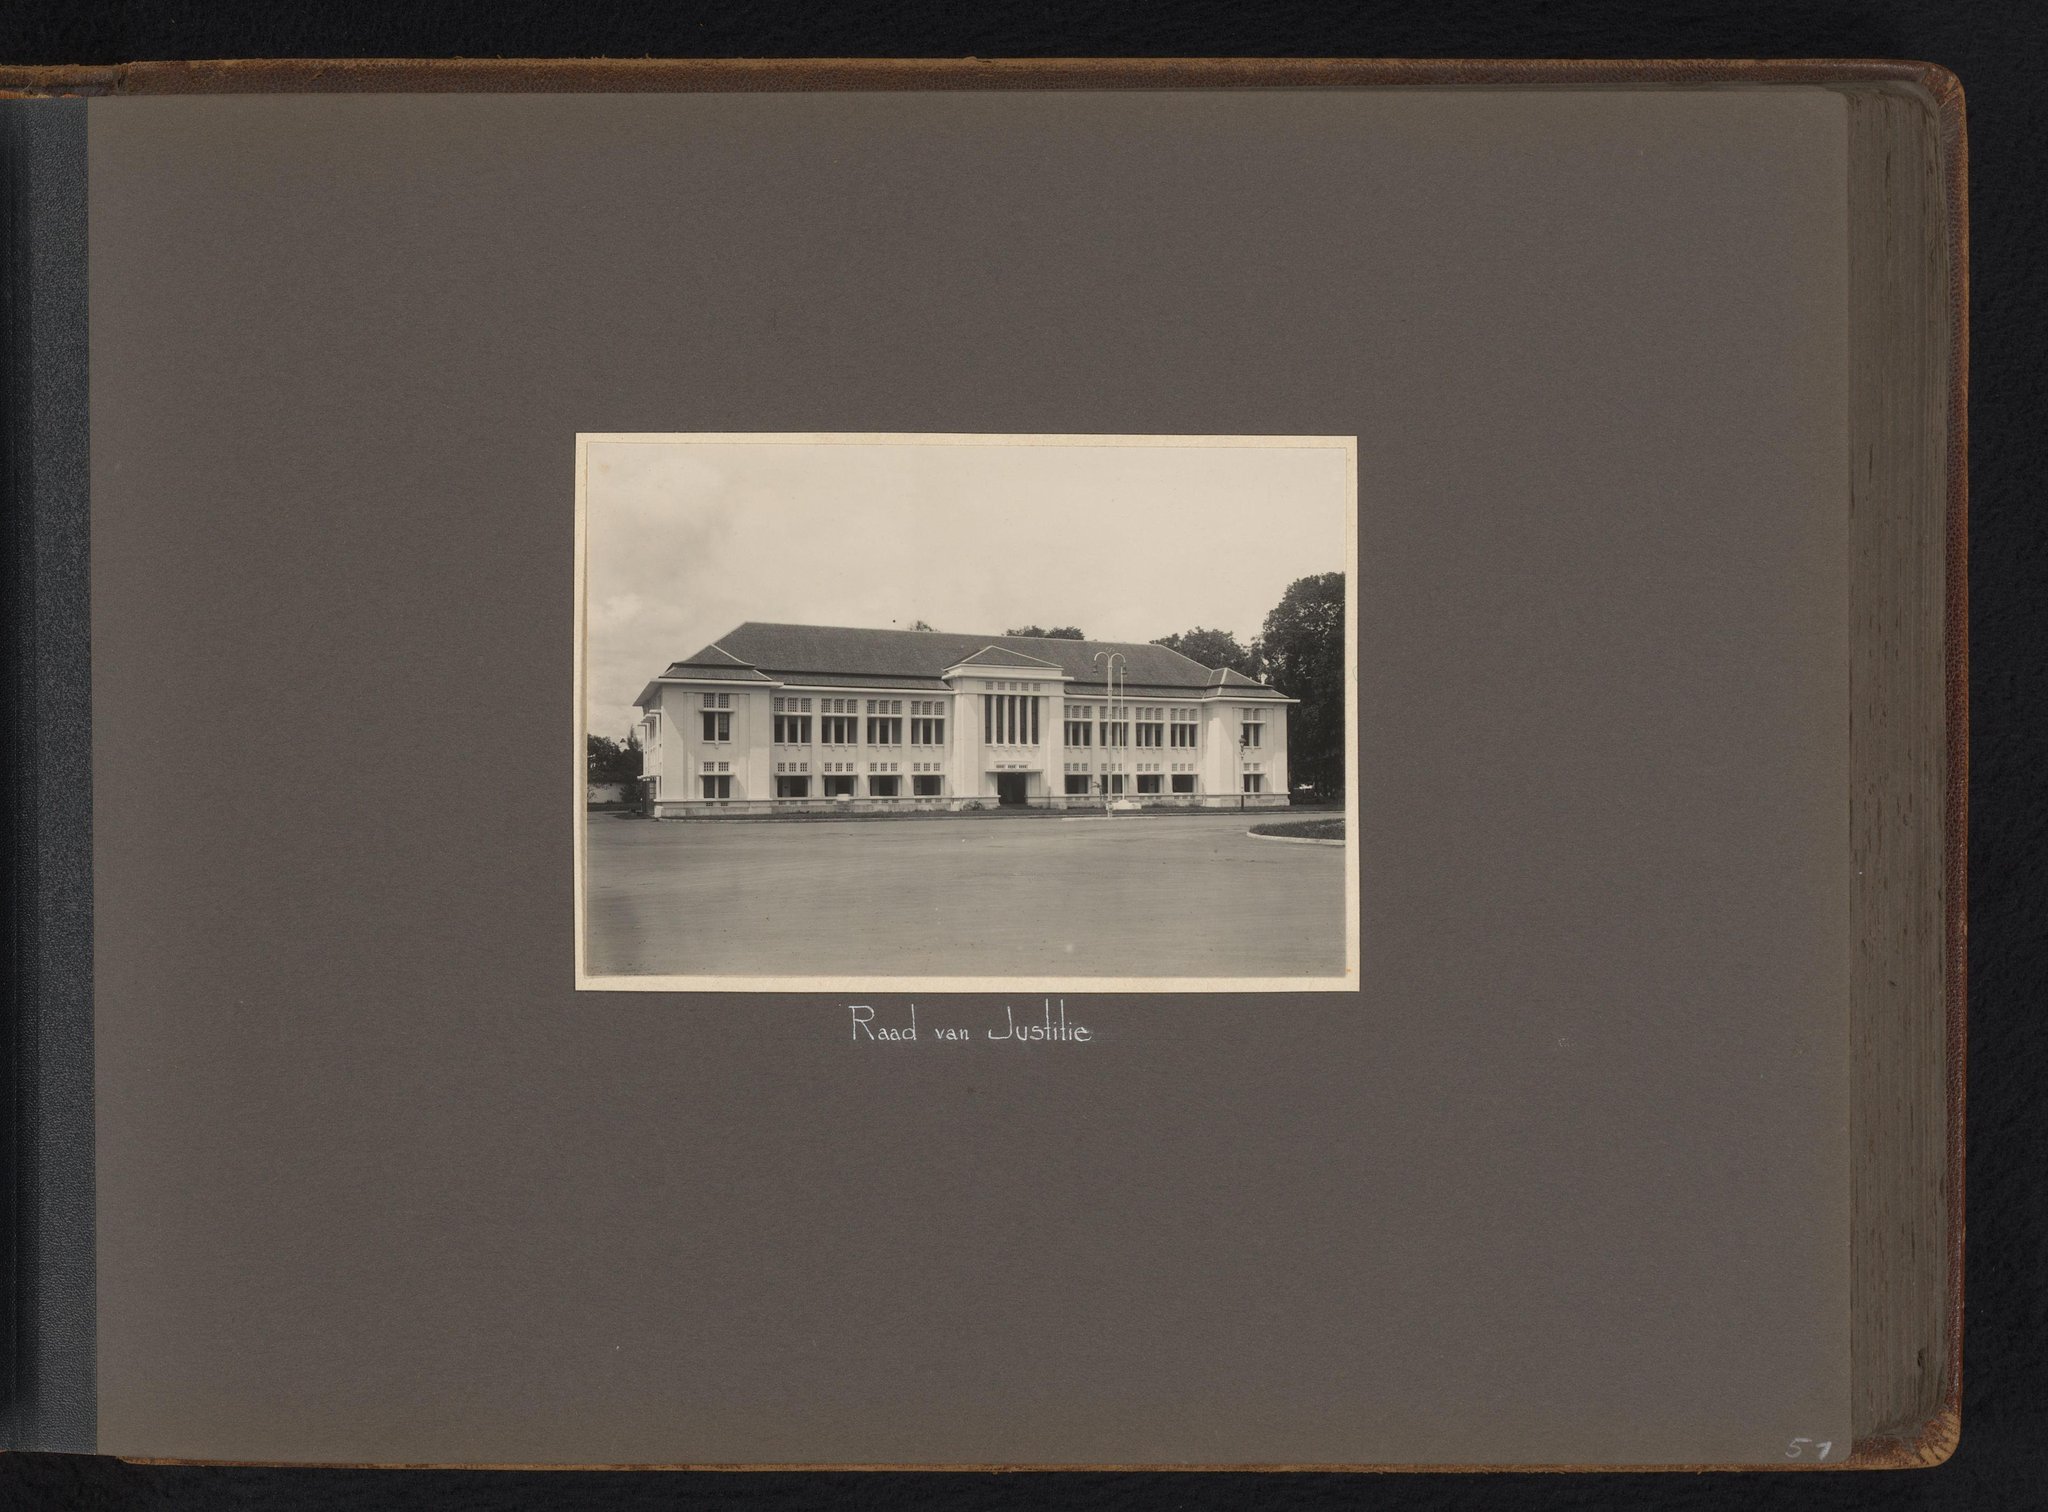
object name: photograph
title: Raad van Justitie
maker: Anonymous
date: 1925-1931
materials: cardboard, photographic support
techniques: gelatin silver print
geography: semarang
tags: semarang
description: Albumblad met één foto: het gebouw van de Raad van Justitie te Semarang. Onderdeel van het fotoalbum aangeboden aan S. Koster door de Vereeniging van Hoogere Politie Ambtenaren in Nederlandsch-Indië in 1931.